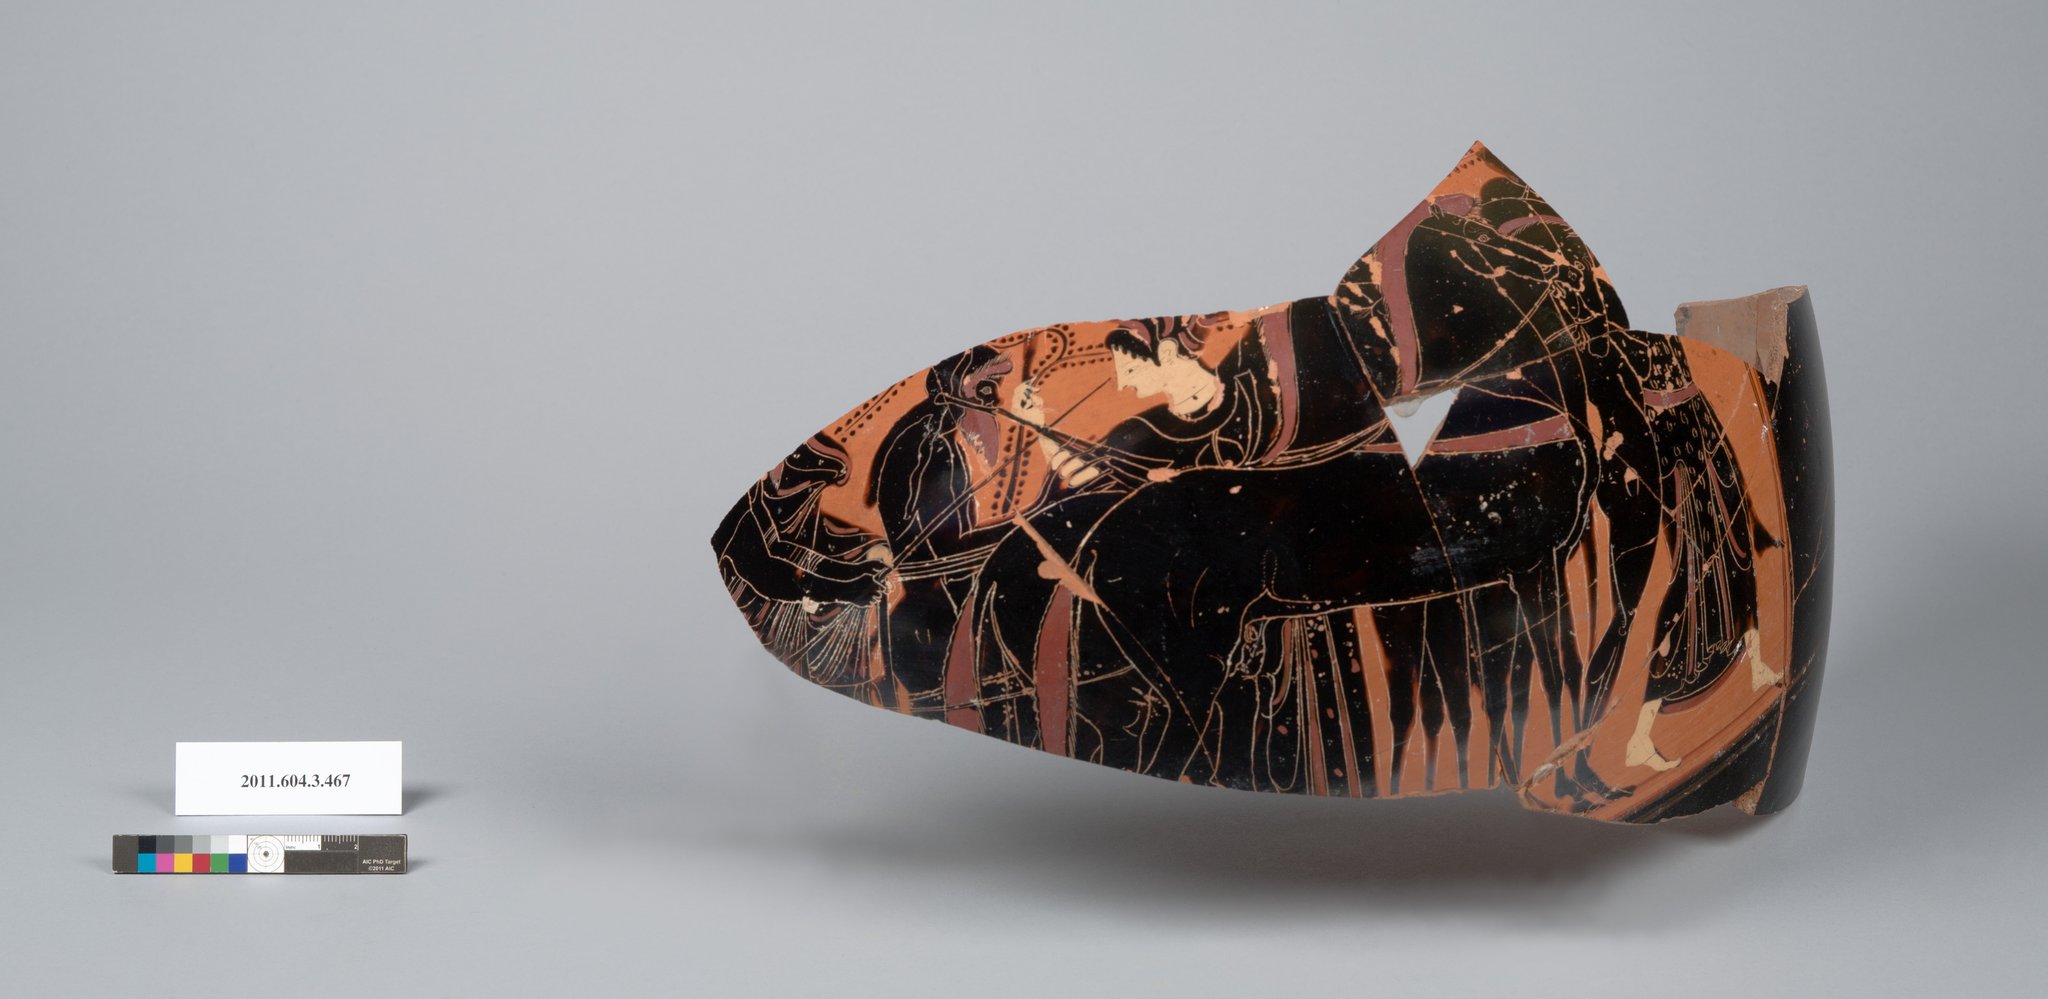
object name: amphora fragment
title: Terracotta fragment of an amphora (jar)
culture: greek, attic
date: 550-526 BCE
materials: terracotta